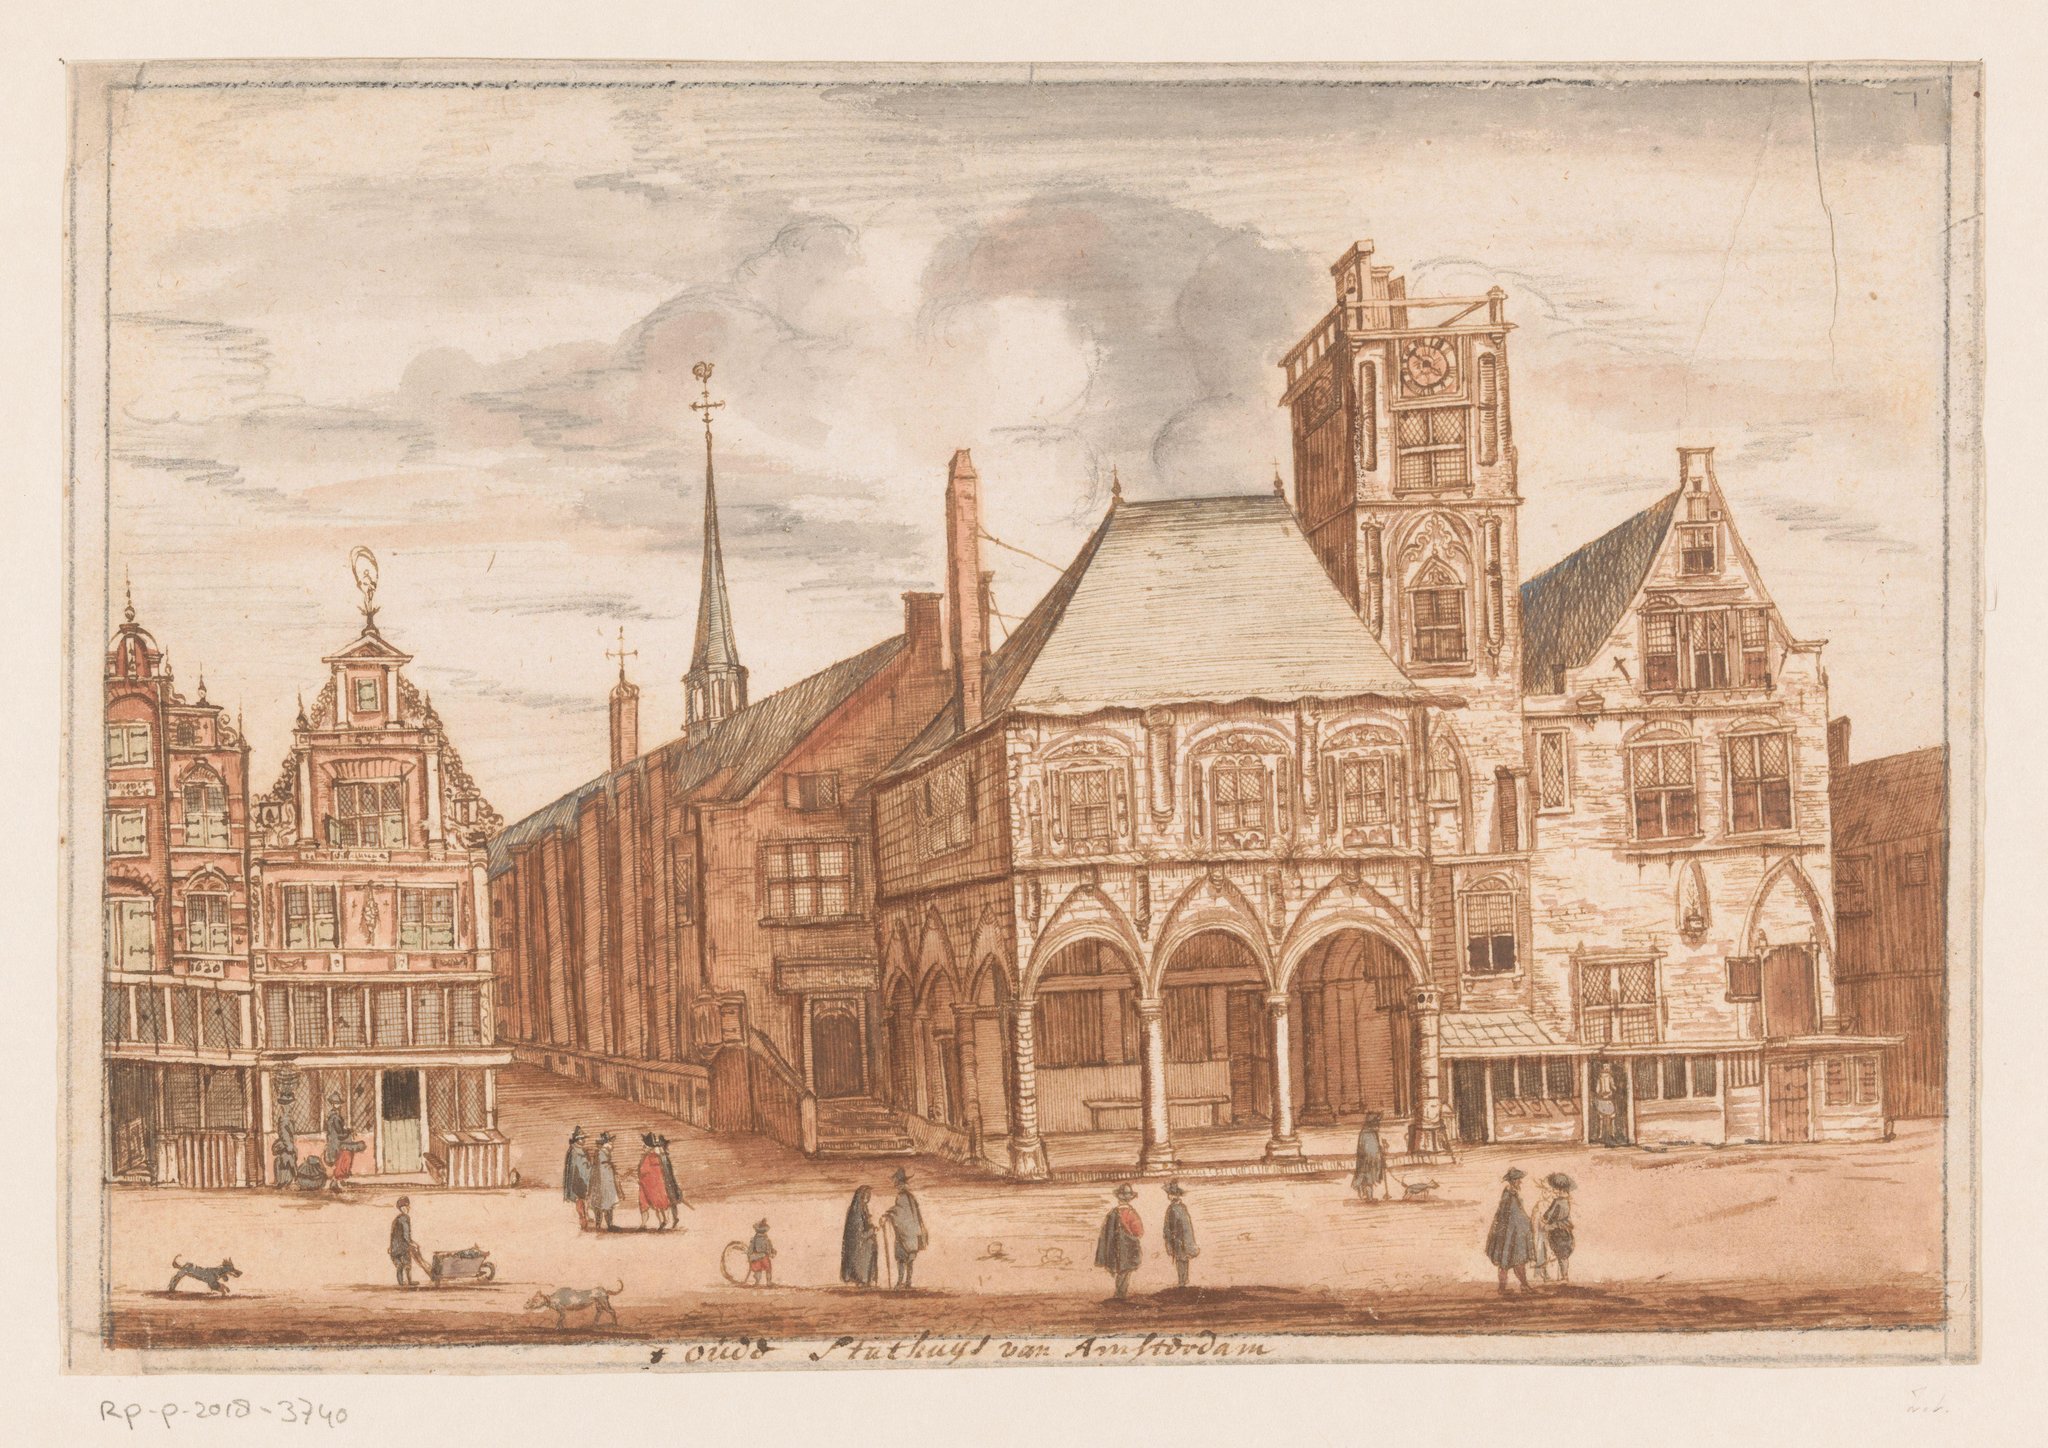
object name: drawing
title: T oudt Stathuys van Amsterdam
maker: Anonymous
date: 1625-1652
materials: paper, pencil, watercolor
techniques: brush, hand coloring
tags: civic architecture; edifices; dwellings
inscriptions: inscription: ‘t oudt Stathuys van Amsterdam’